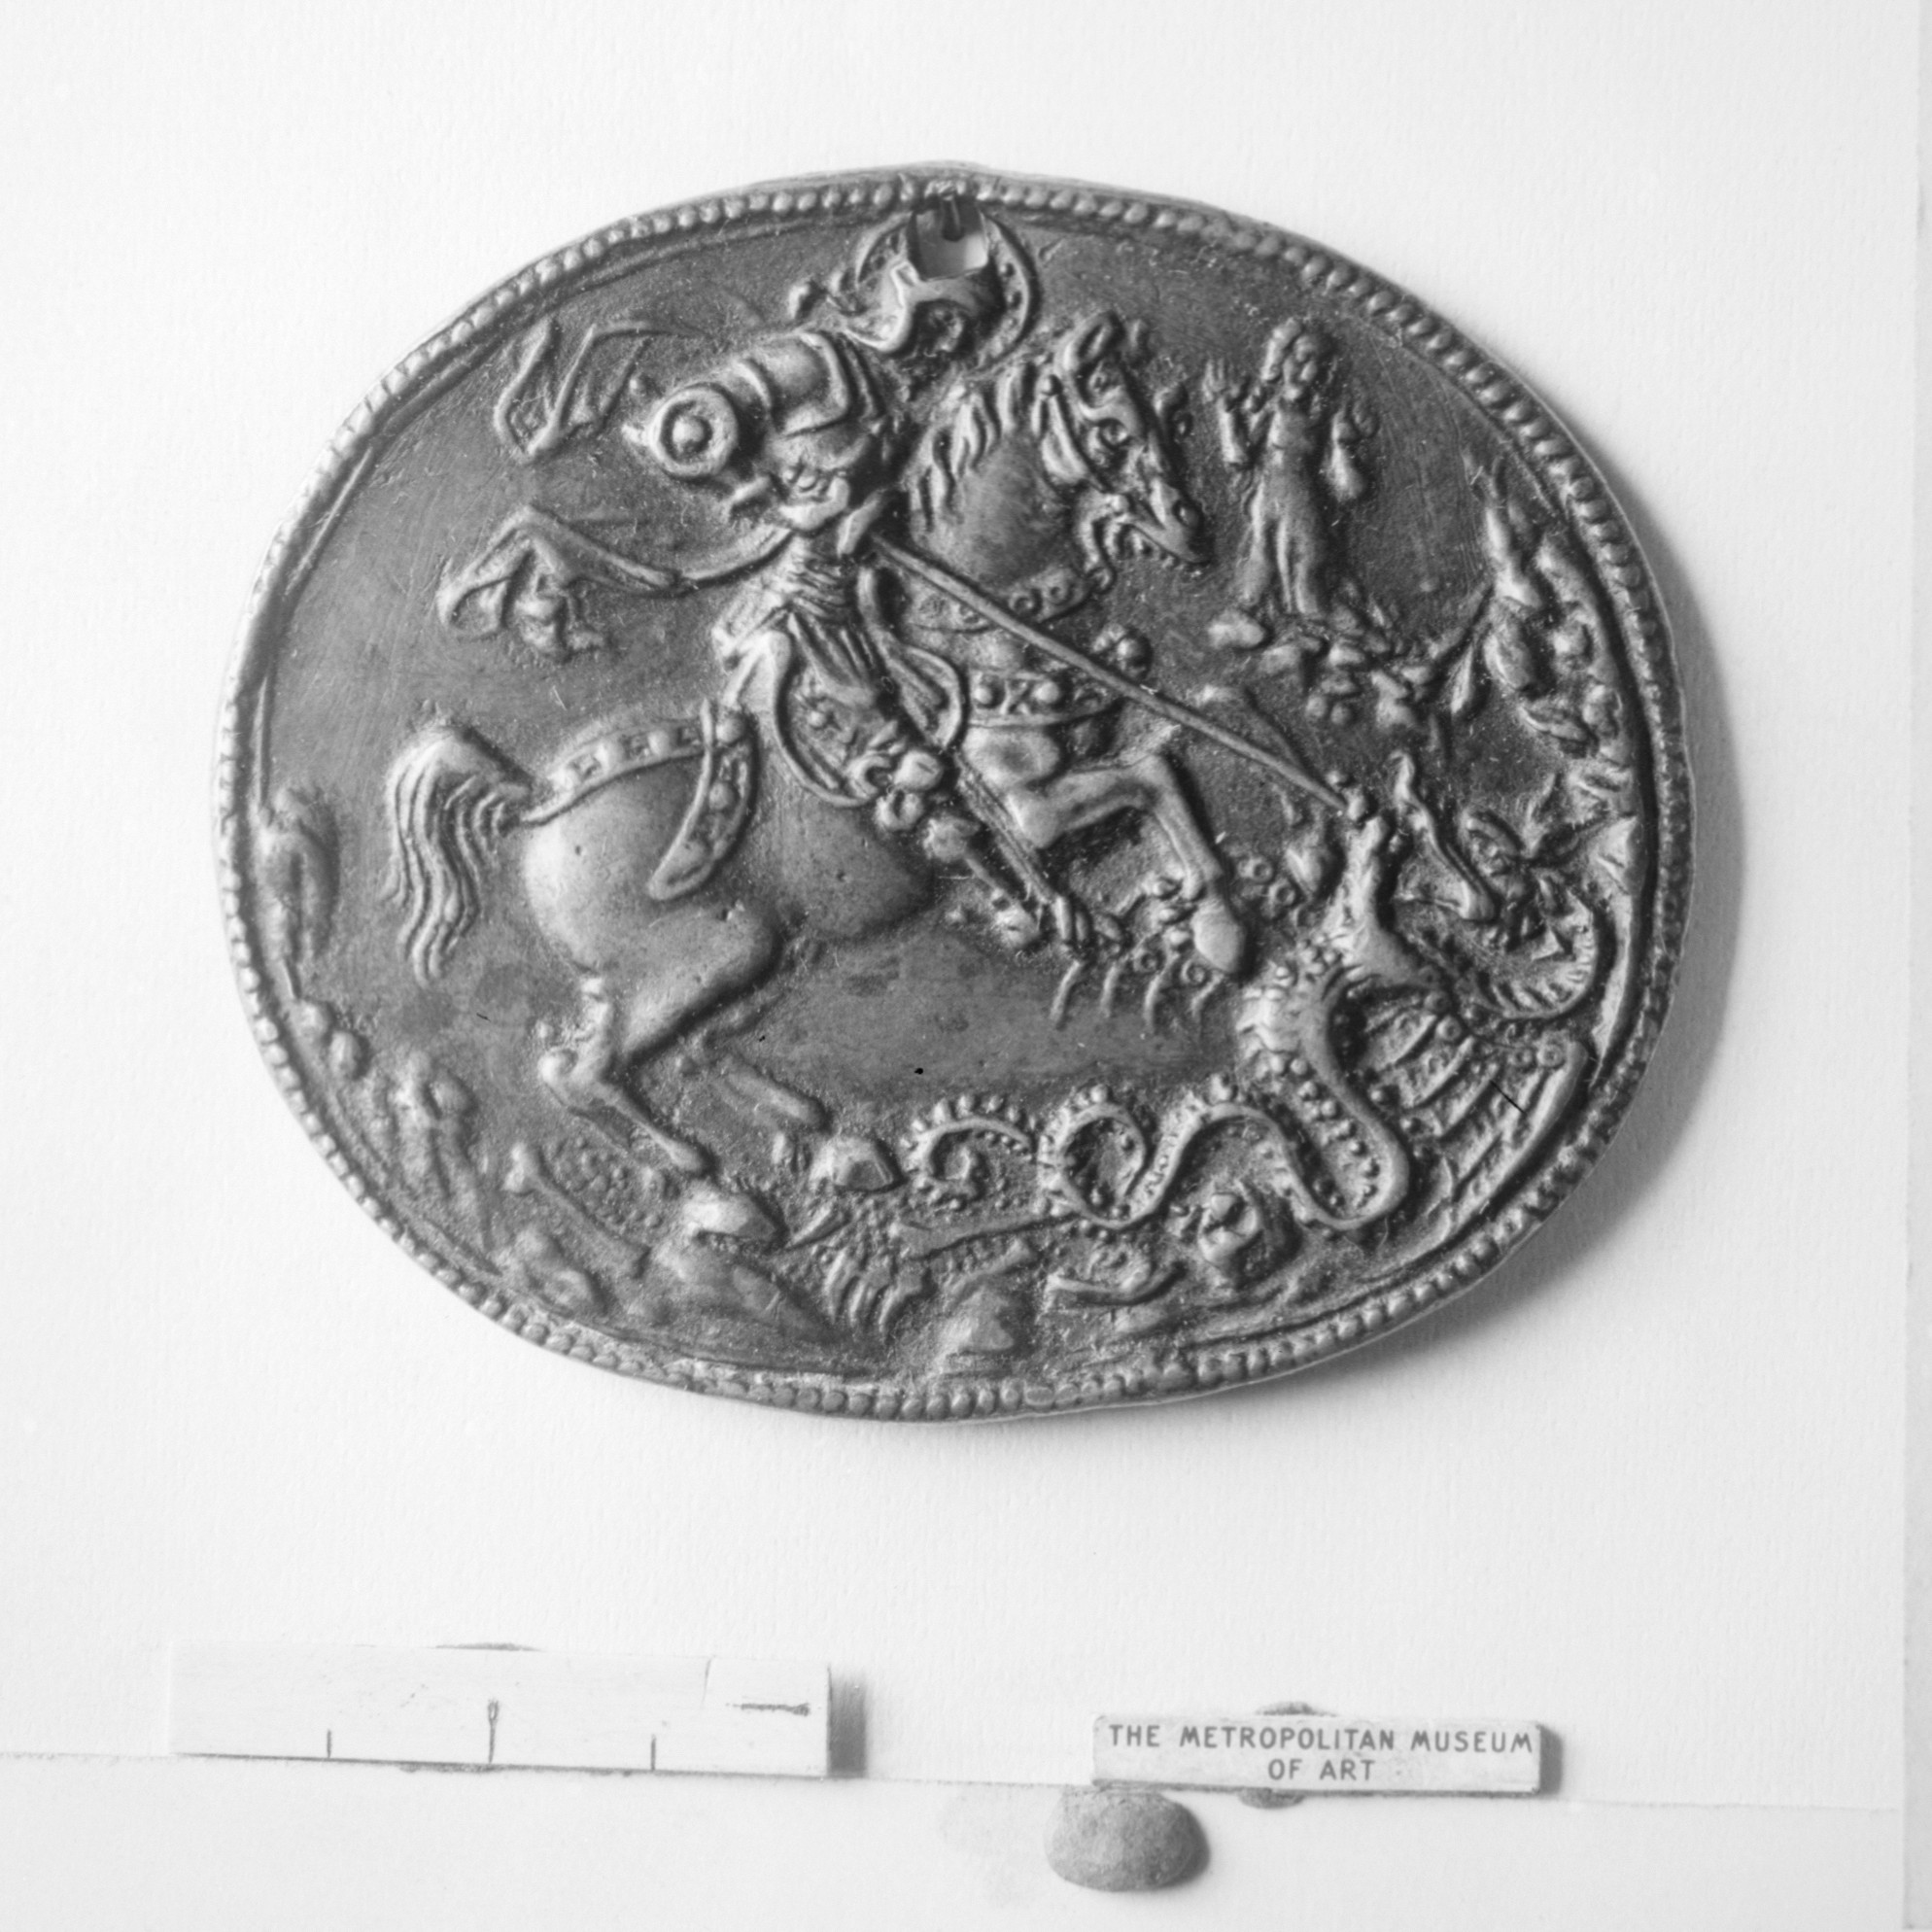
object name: plaquette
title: Saint George and the Dragon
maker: gian francesco enzola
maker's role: maker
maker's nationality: italian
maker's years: 1456-1478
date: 1467-1500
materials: bronze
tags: battles,dragons,horses,saint george